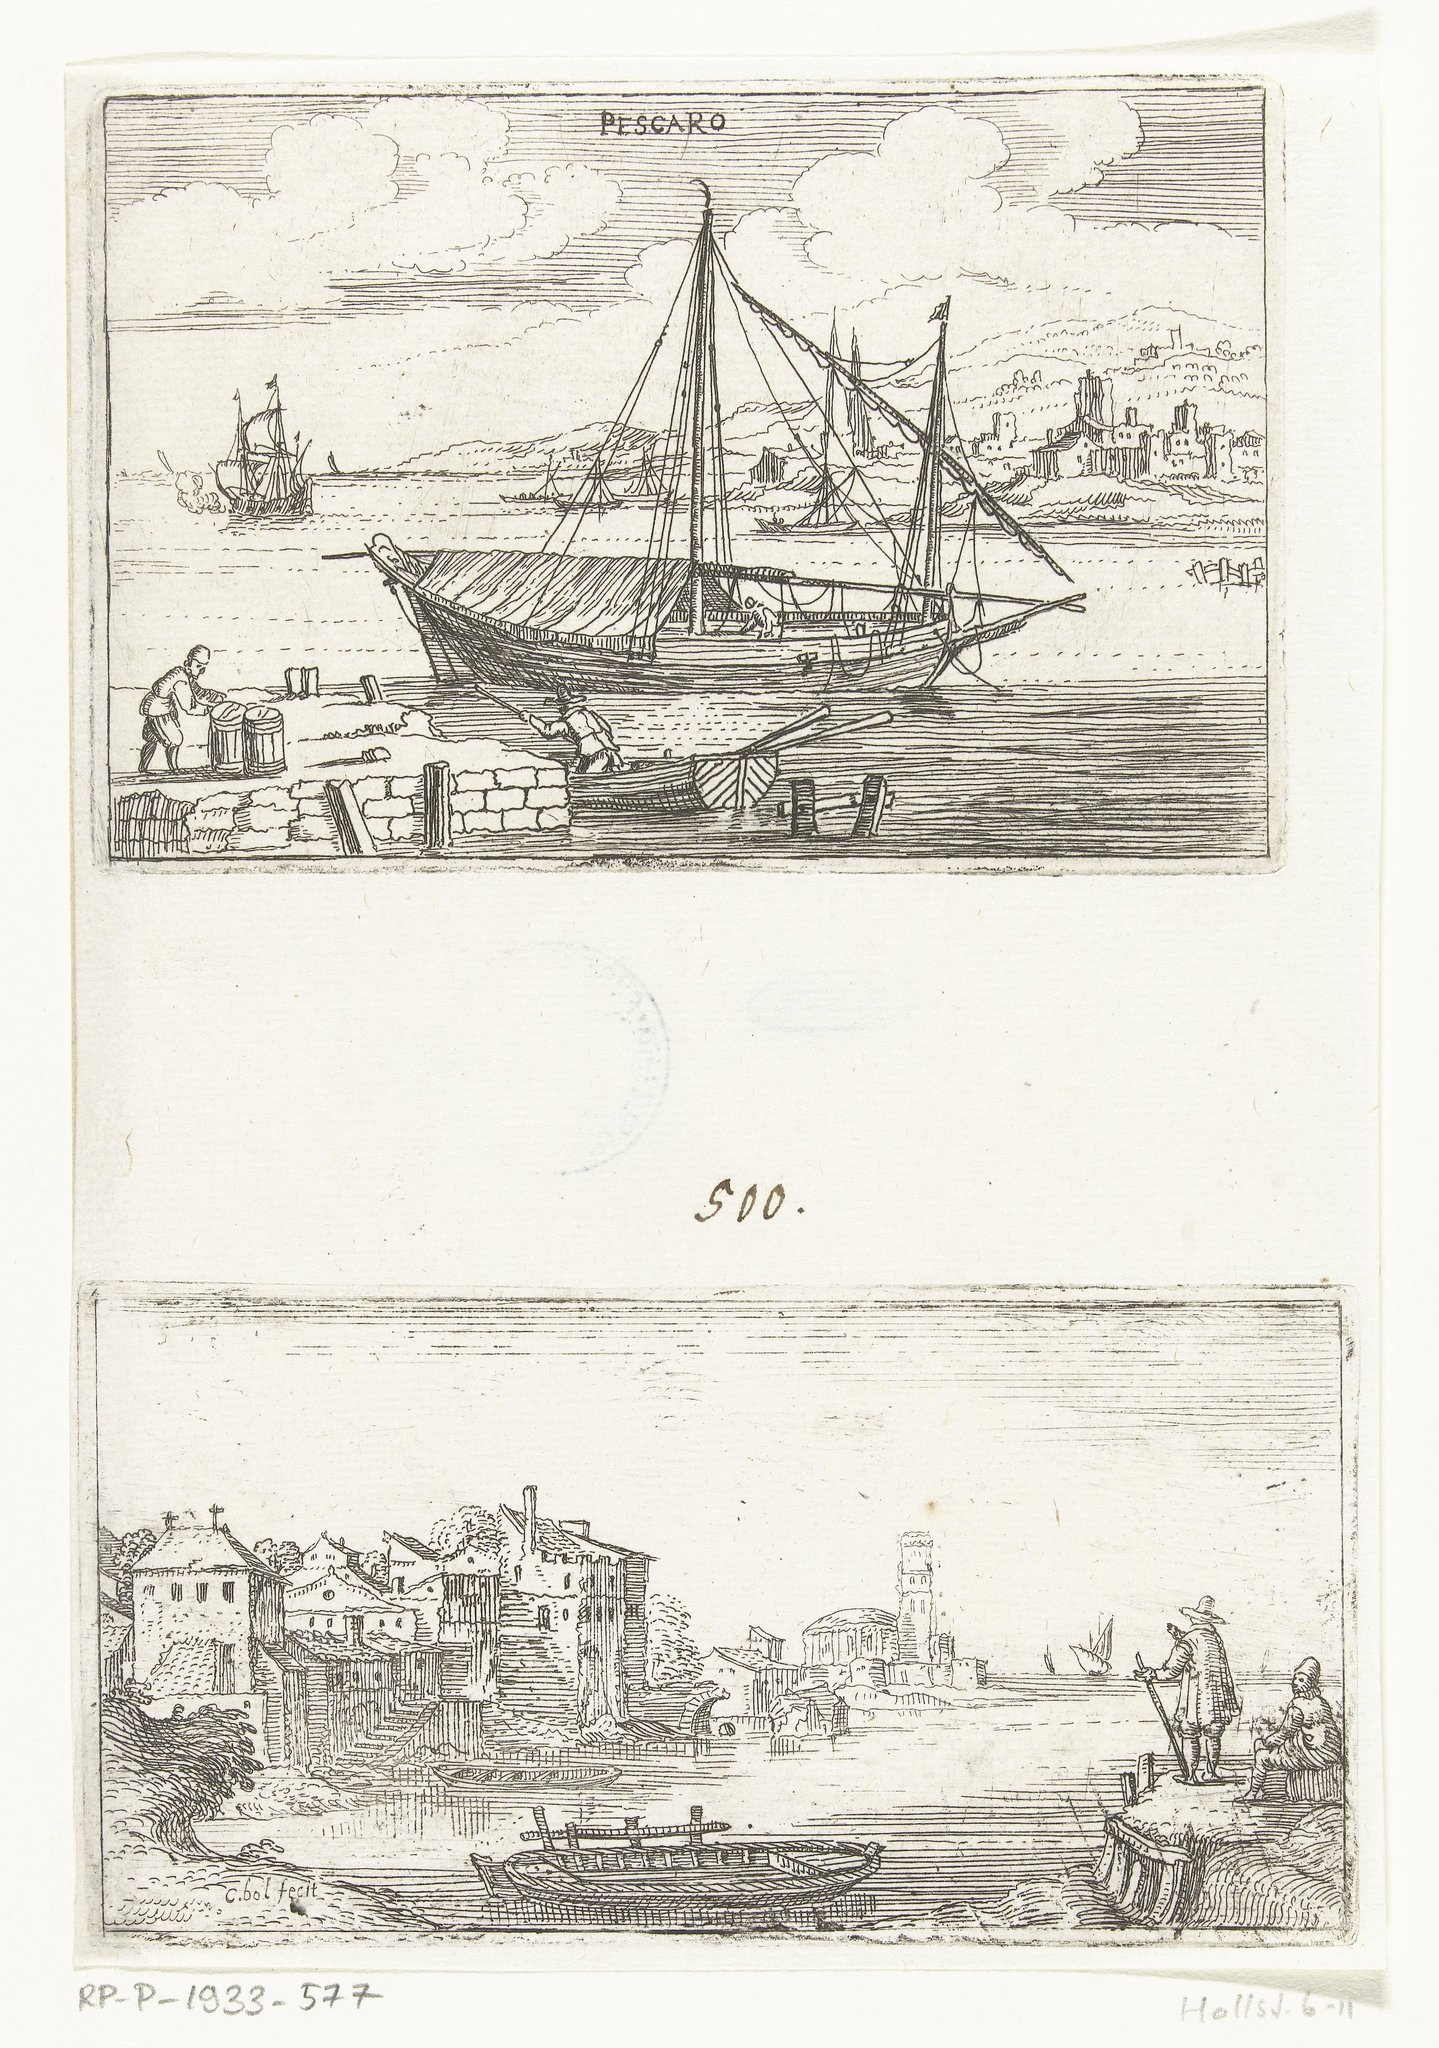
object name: print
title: Landschappen en marines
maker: cornelis bol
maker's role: print maker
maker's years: 1589-1666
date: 1615-1666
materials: paper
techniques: etching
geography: netherlands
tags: prospect of city, town panorama, silhouette of city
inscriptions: number: ‘500.’, collector's mark: Lugt 2542, collector's mark: Lugt 2228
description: Twee platen afgedrukt op een vel papier. Boven een gezicht op het stadje Pescara in Italië, in de haven liggen vissersboten. Onder, huizen aan een baai gelegen. Een roeiboot ligt op het strand en twee mannen staan op de kade.